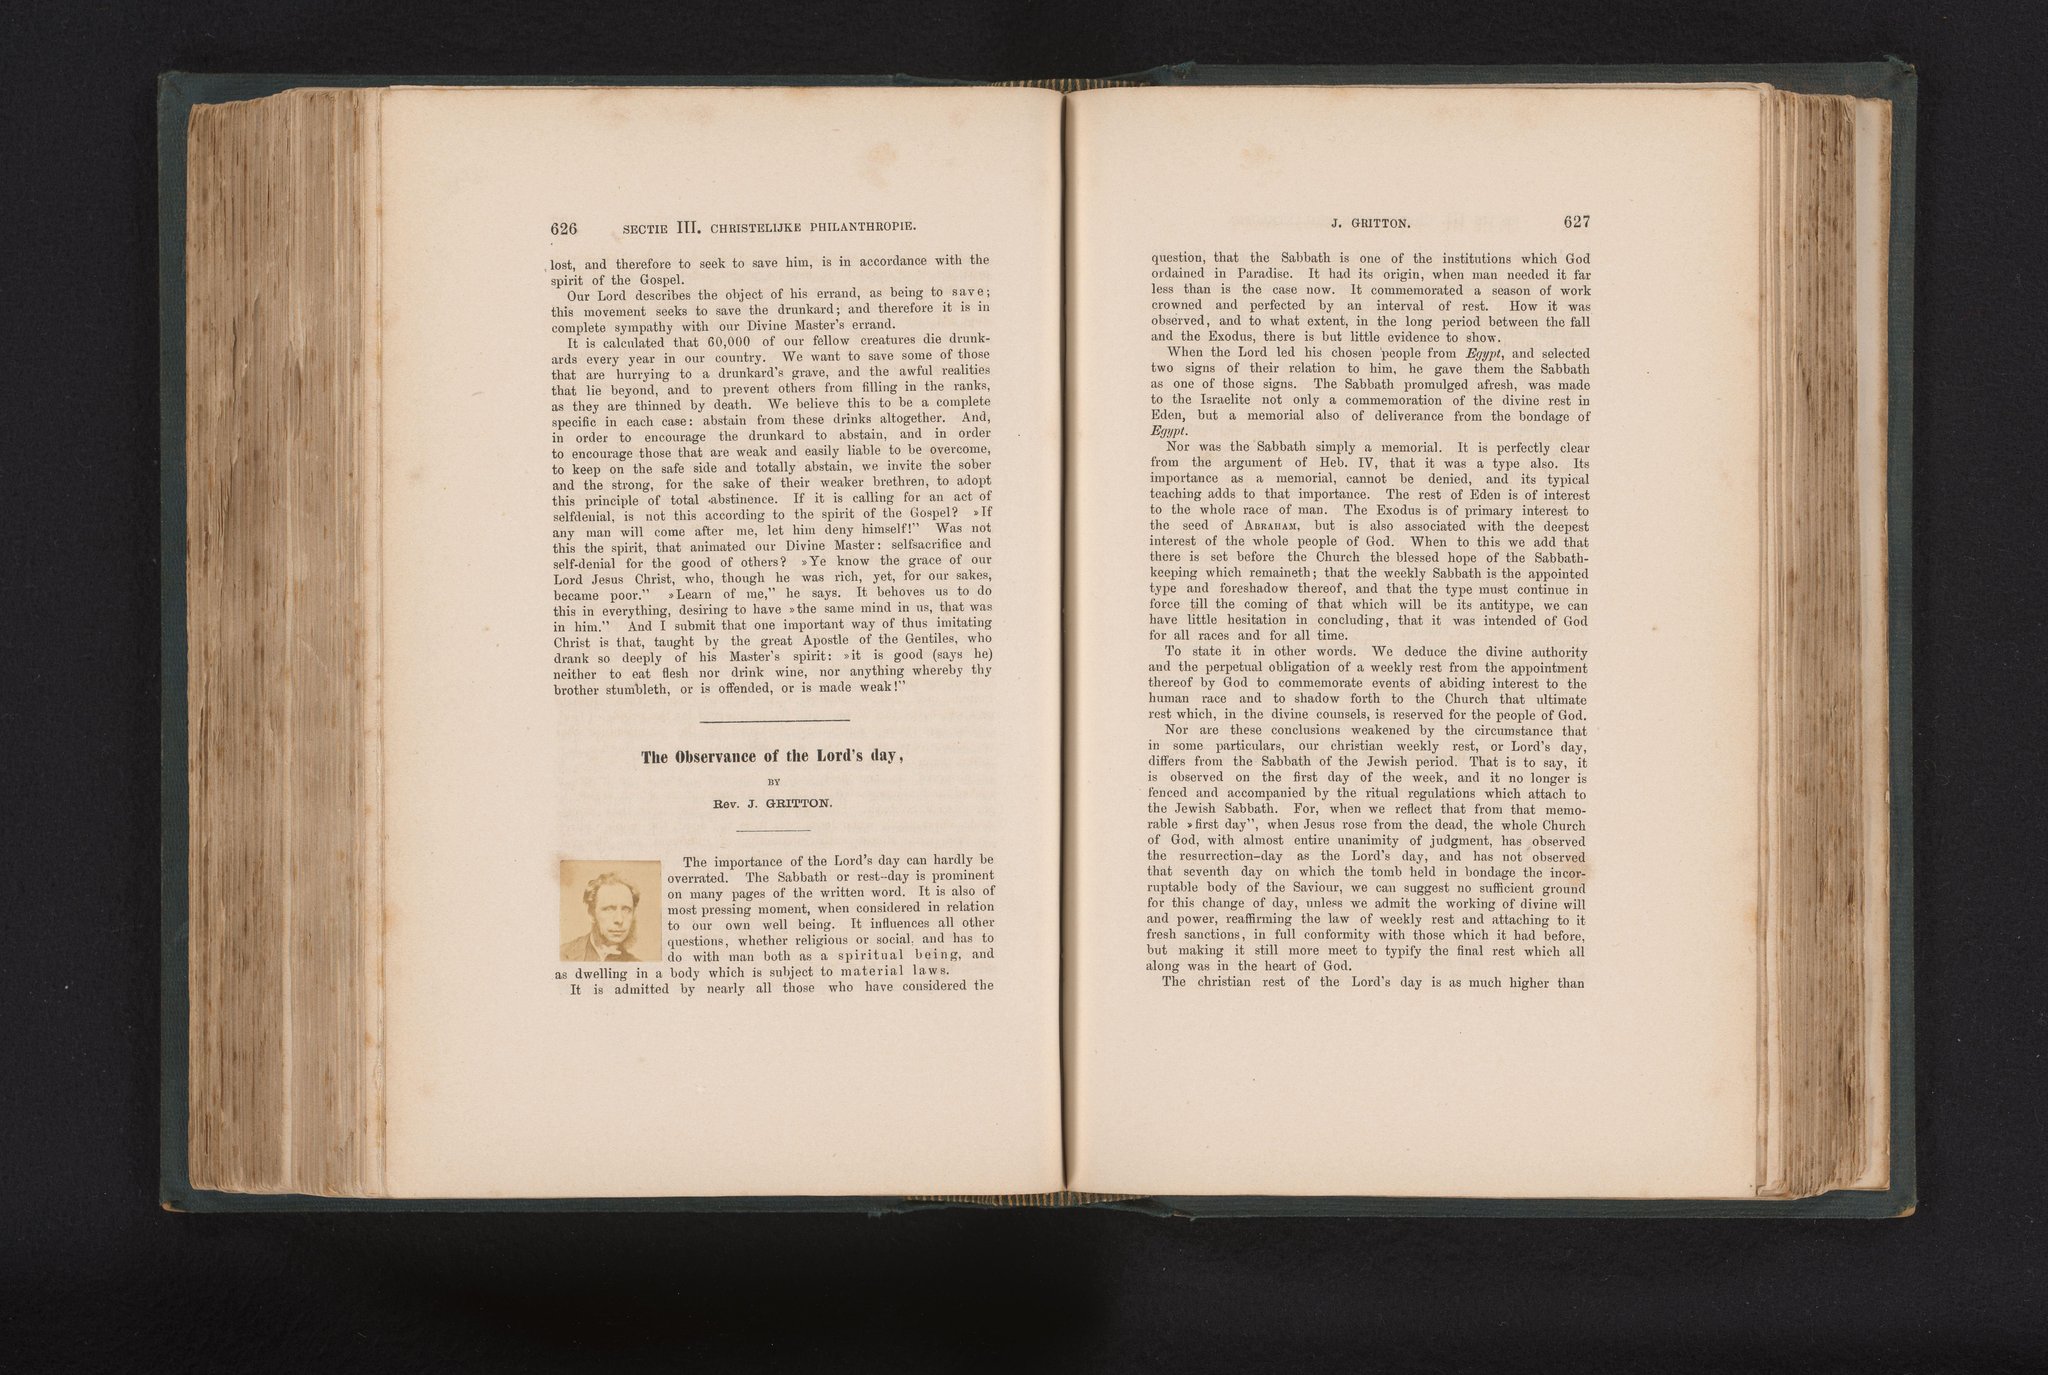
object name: photograph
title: Portret van predikant J. Gritton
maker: Anonymous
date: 1855-1867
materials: paper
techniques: albumen print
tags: adult man, historical persons